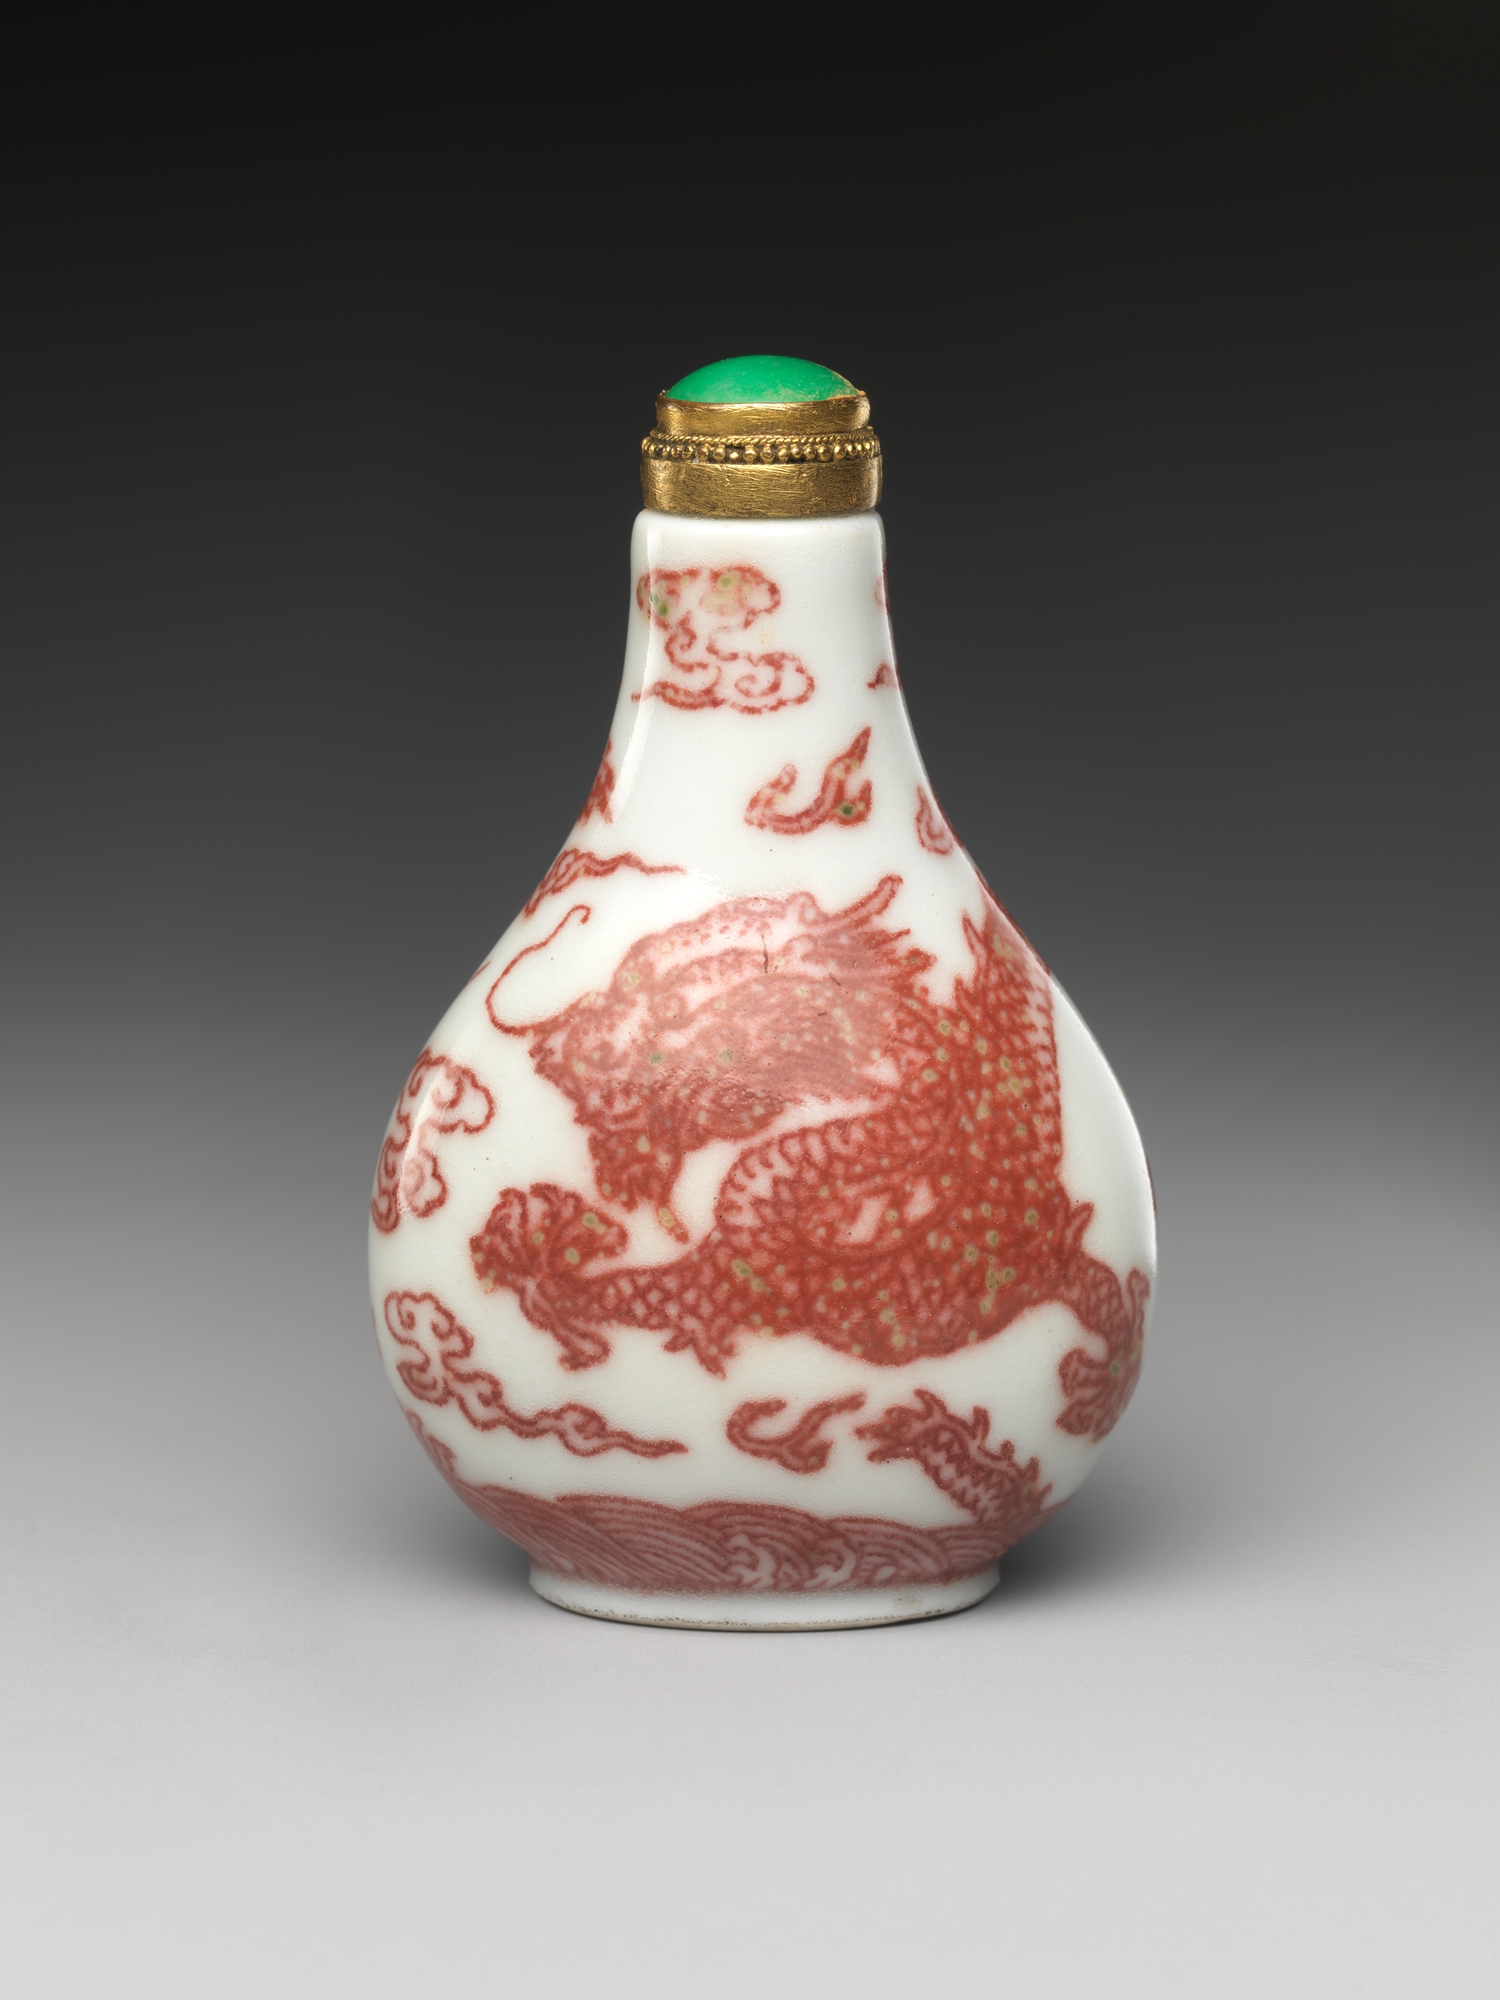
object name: snuff bottle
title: Snuff Bottle with Dragon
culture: chinese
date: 1736-1795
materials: jade, porcelain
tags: dragons